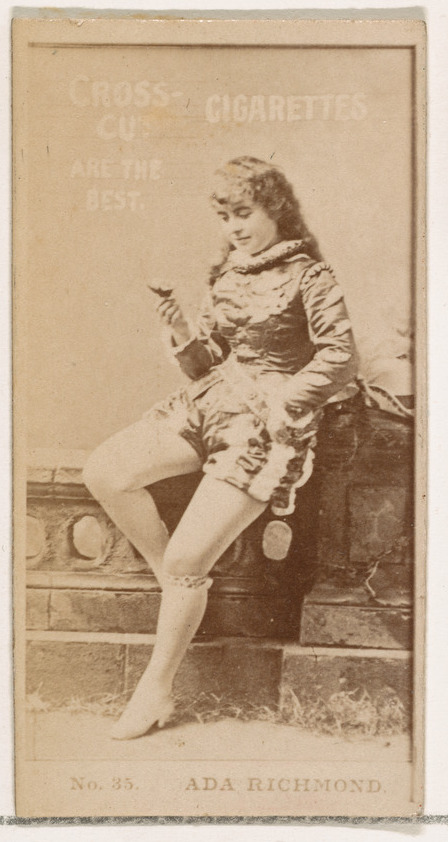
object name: print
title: Card Number 35, Ada Richmond, from the Actors and Actresses series (N145-2) issued by Duke Sons & Co. to promote Cross Cut Cigarettes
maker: w. duke, sons & co.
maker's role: publisher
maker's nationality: american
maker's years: 1870-1920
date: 1880-1889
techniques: albumen silver print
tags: portraits,women,actresses